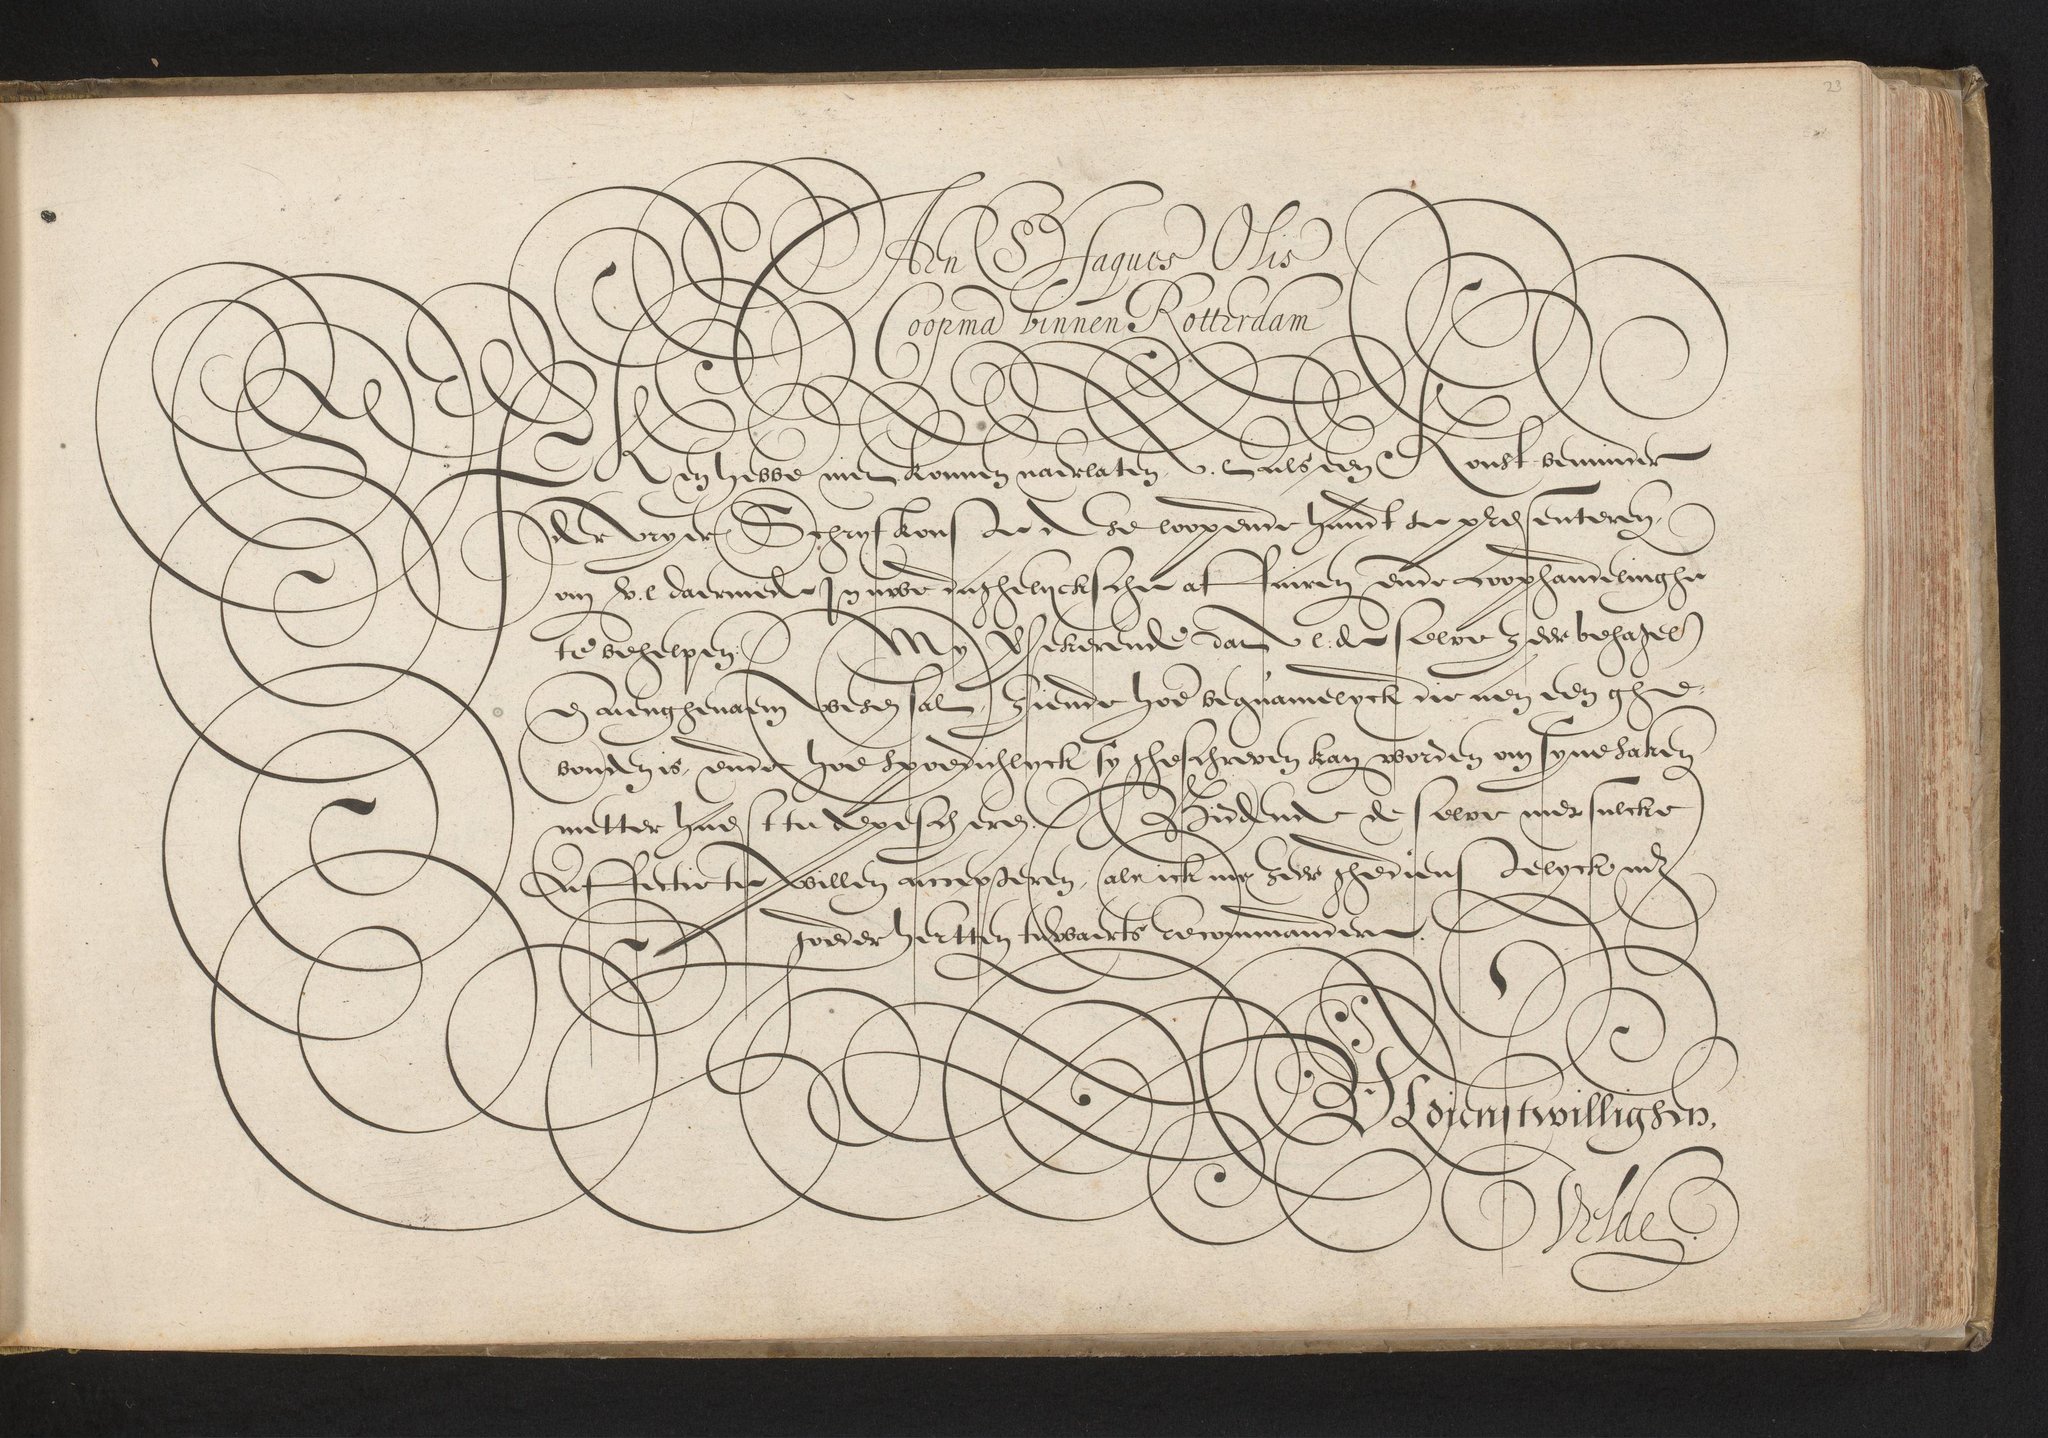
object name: ornament print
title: Spieghel der schrijfkonste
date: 1605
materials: paper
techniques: engraving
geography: haarlem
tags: calligraphy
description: Schrijfvoorbeeld met de aanhef: Aen S. Jacques Olis, coopman binnen Rotterdam. Daaronder in een andere letter een geornamenteerde initiaal I en negen regels tekst in het Nederlands: Ick en hebbe niet konne naerlaten ... De tekst is omlijst door krulwerk. De prent maakt deel uit van een album.